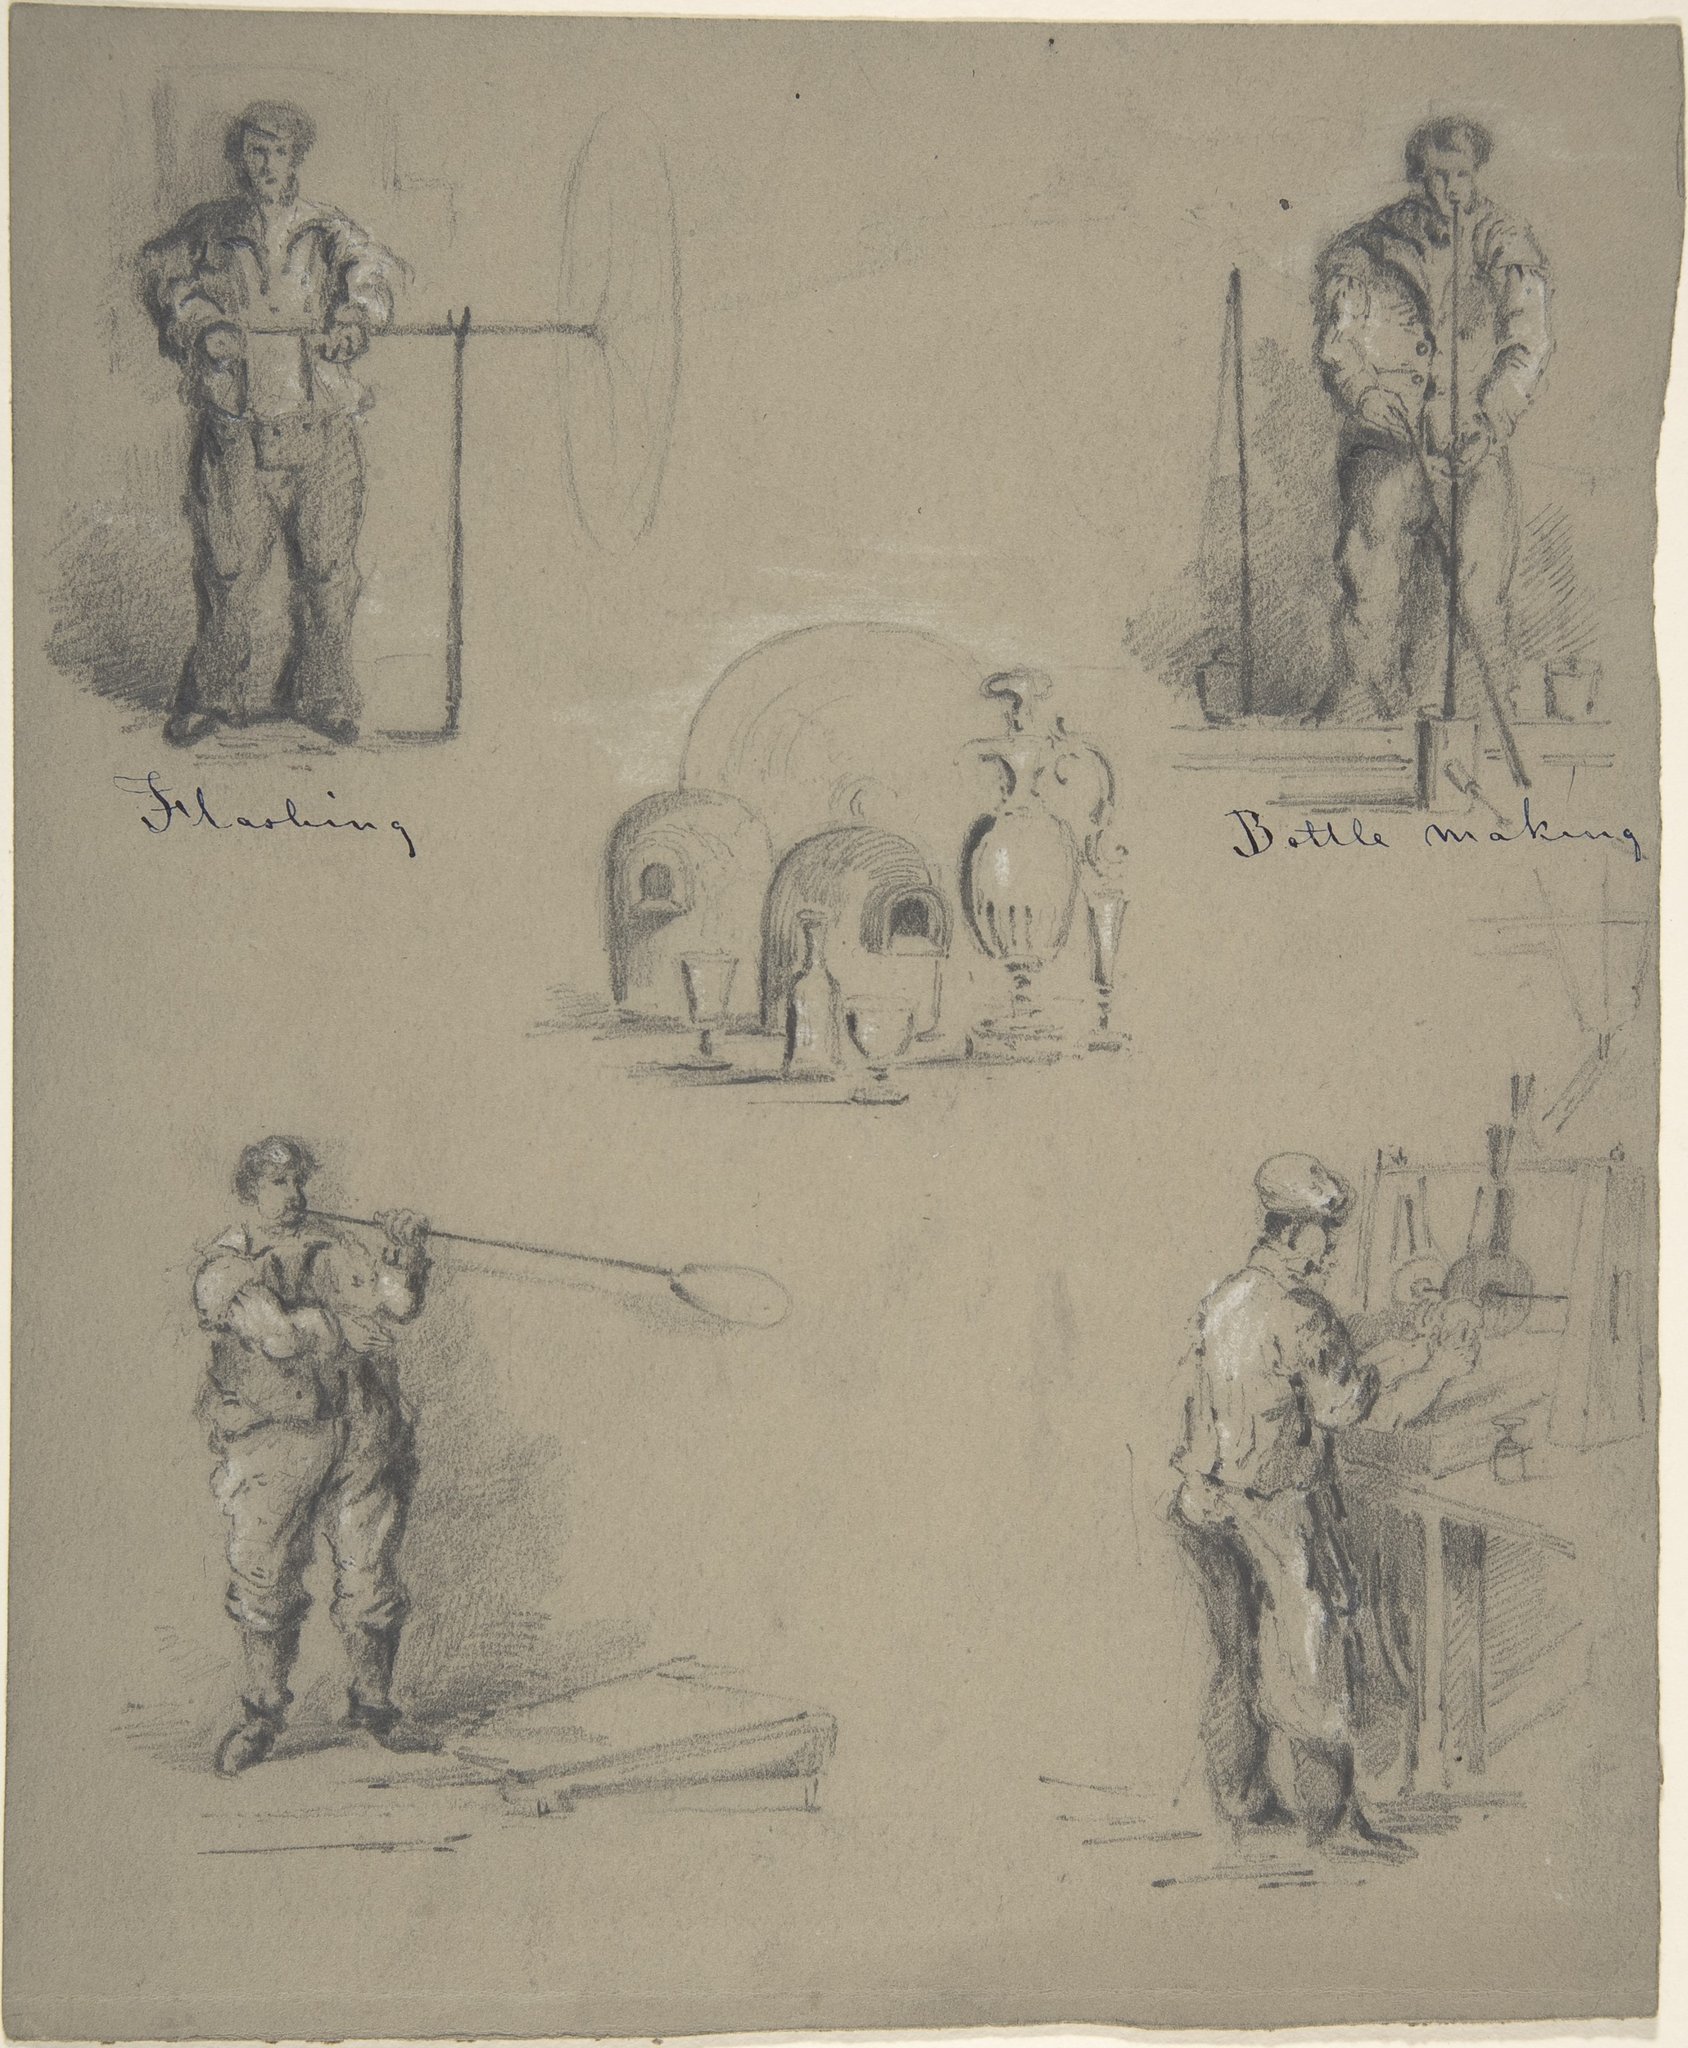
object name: drawing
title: Five images showing the processes of manufacturing glass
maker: anonymous, british, 19th century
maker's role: artist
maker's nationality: british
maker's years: 1800-1900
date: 1801-1900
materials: chalk, graphite, ink, paper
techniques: pen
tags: men,working,tools